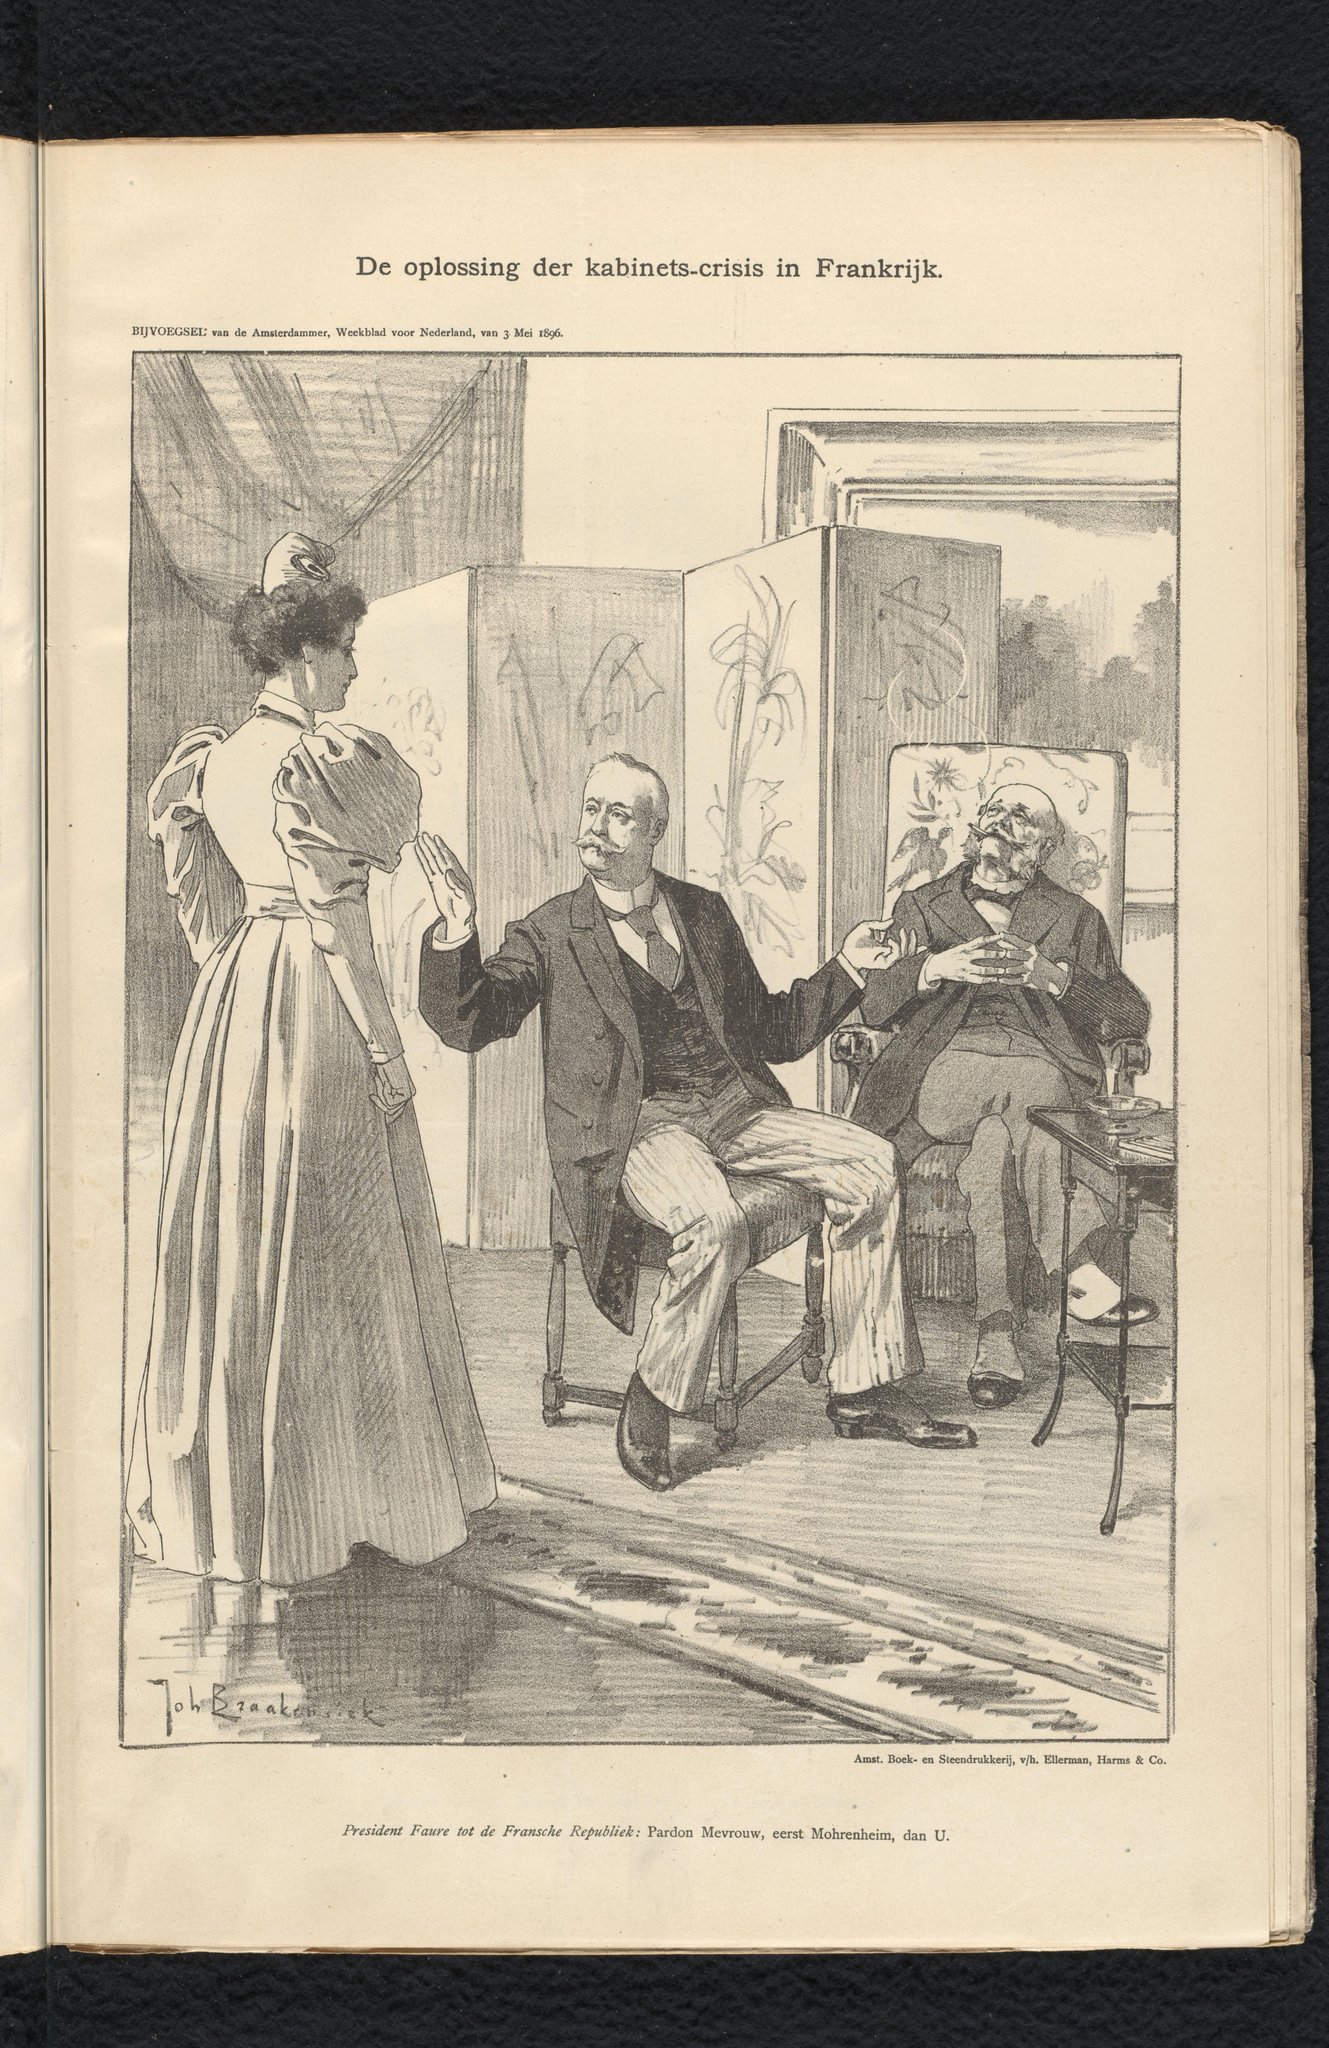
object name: cartoon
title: De oplossing der kabinets-crisis in Frankrijk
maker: johan braakensiek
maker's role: draughtsman, print maker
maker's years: 1858-1940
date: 1896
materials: paper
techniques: lithograph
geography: netherlands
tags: paris, personifications of countries, nations, states, districts, etc., ambassador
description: President Faure laat de Franse Maagd wachten terwijl hij met de Russische ambassadeur Arthur von Mohrenheim in gesprek is.